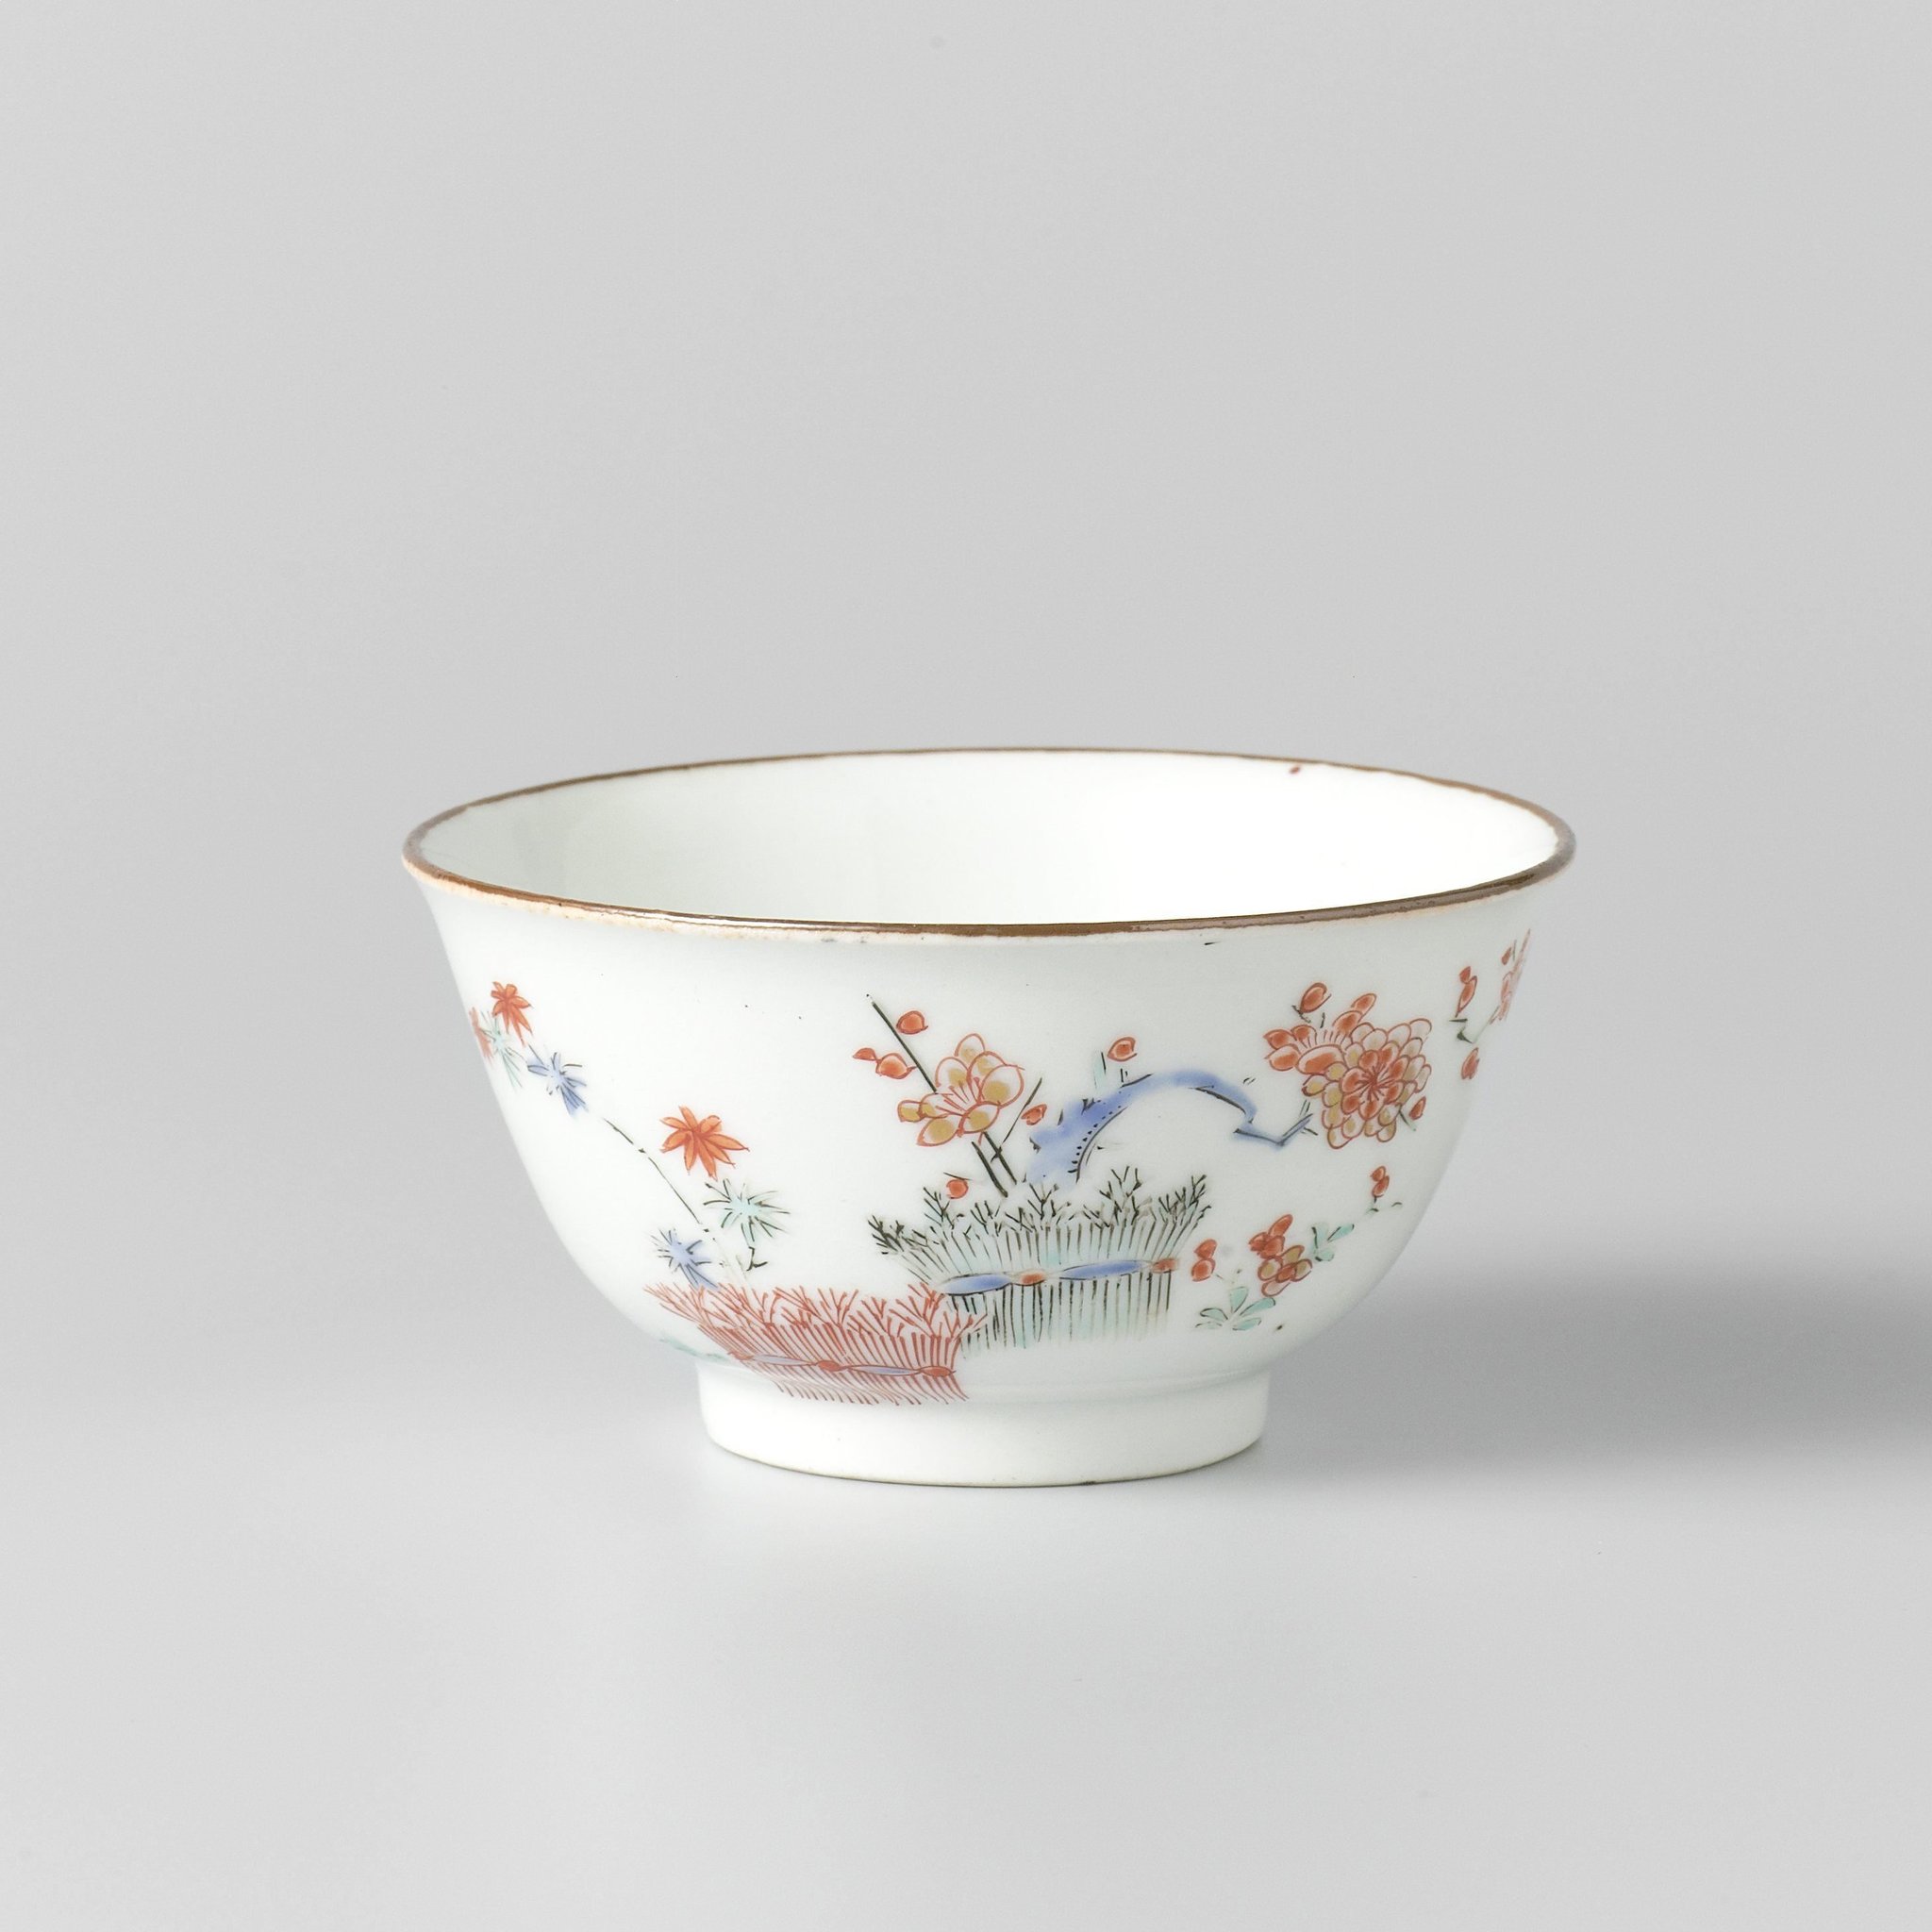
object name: cup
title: Cup with hedges, bamboo, prunus and hoo-bird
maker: Anonymous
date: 1670-1690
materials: glaze, gold, paint, porcelain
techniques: firing, gilding, turning, vitrification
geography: arita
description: Cup and saucer, c. 1700 - 1725.